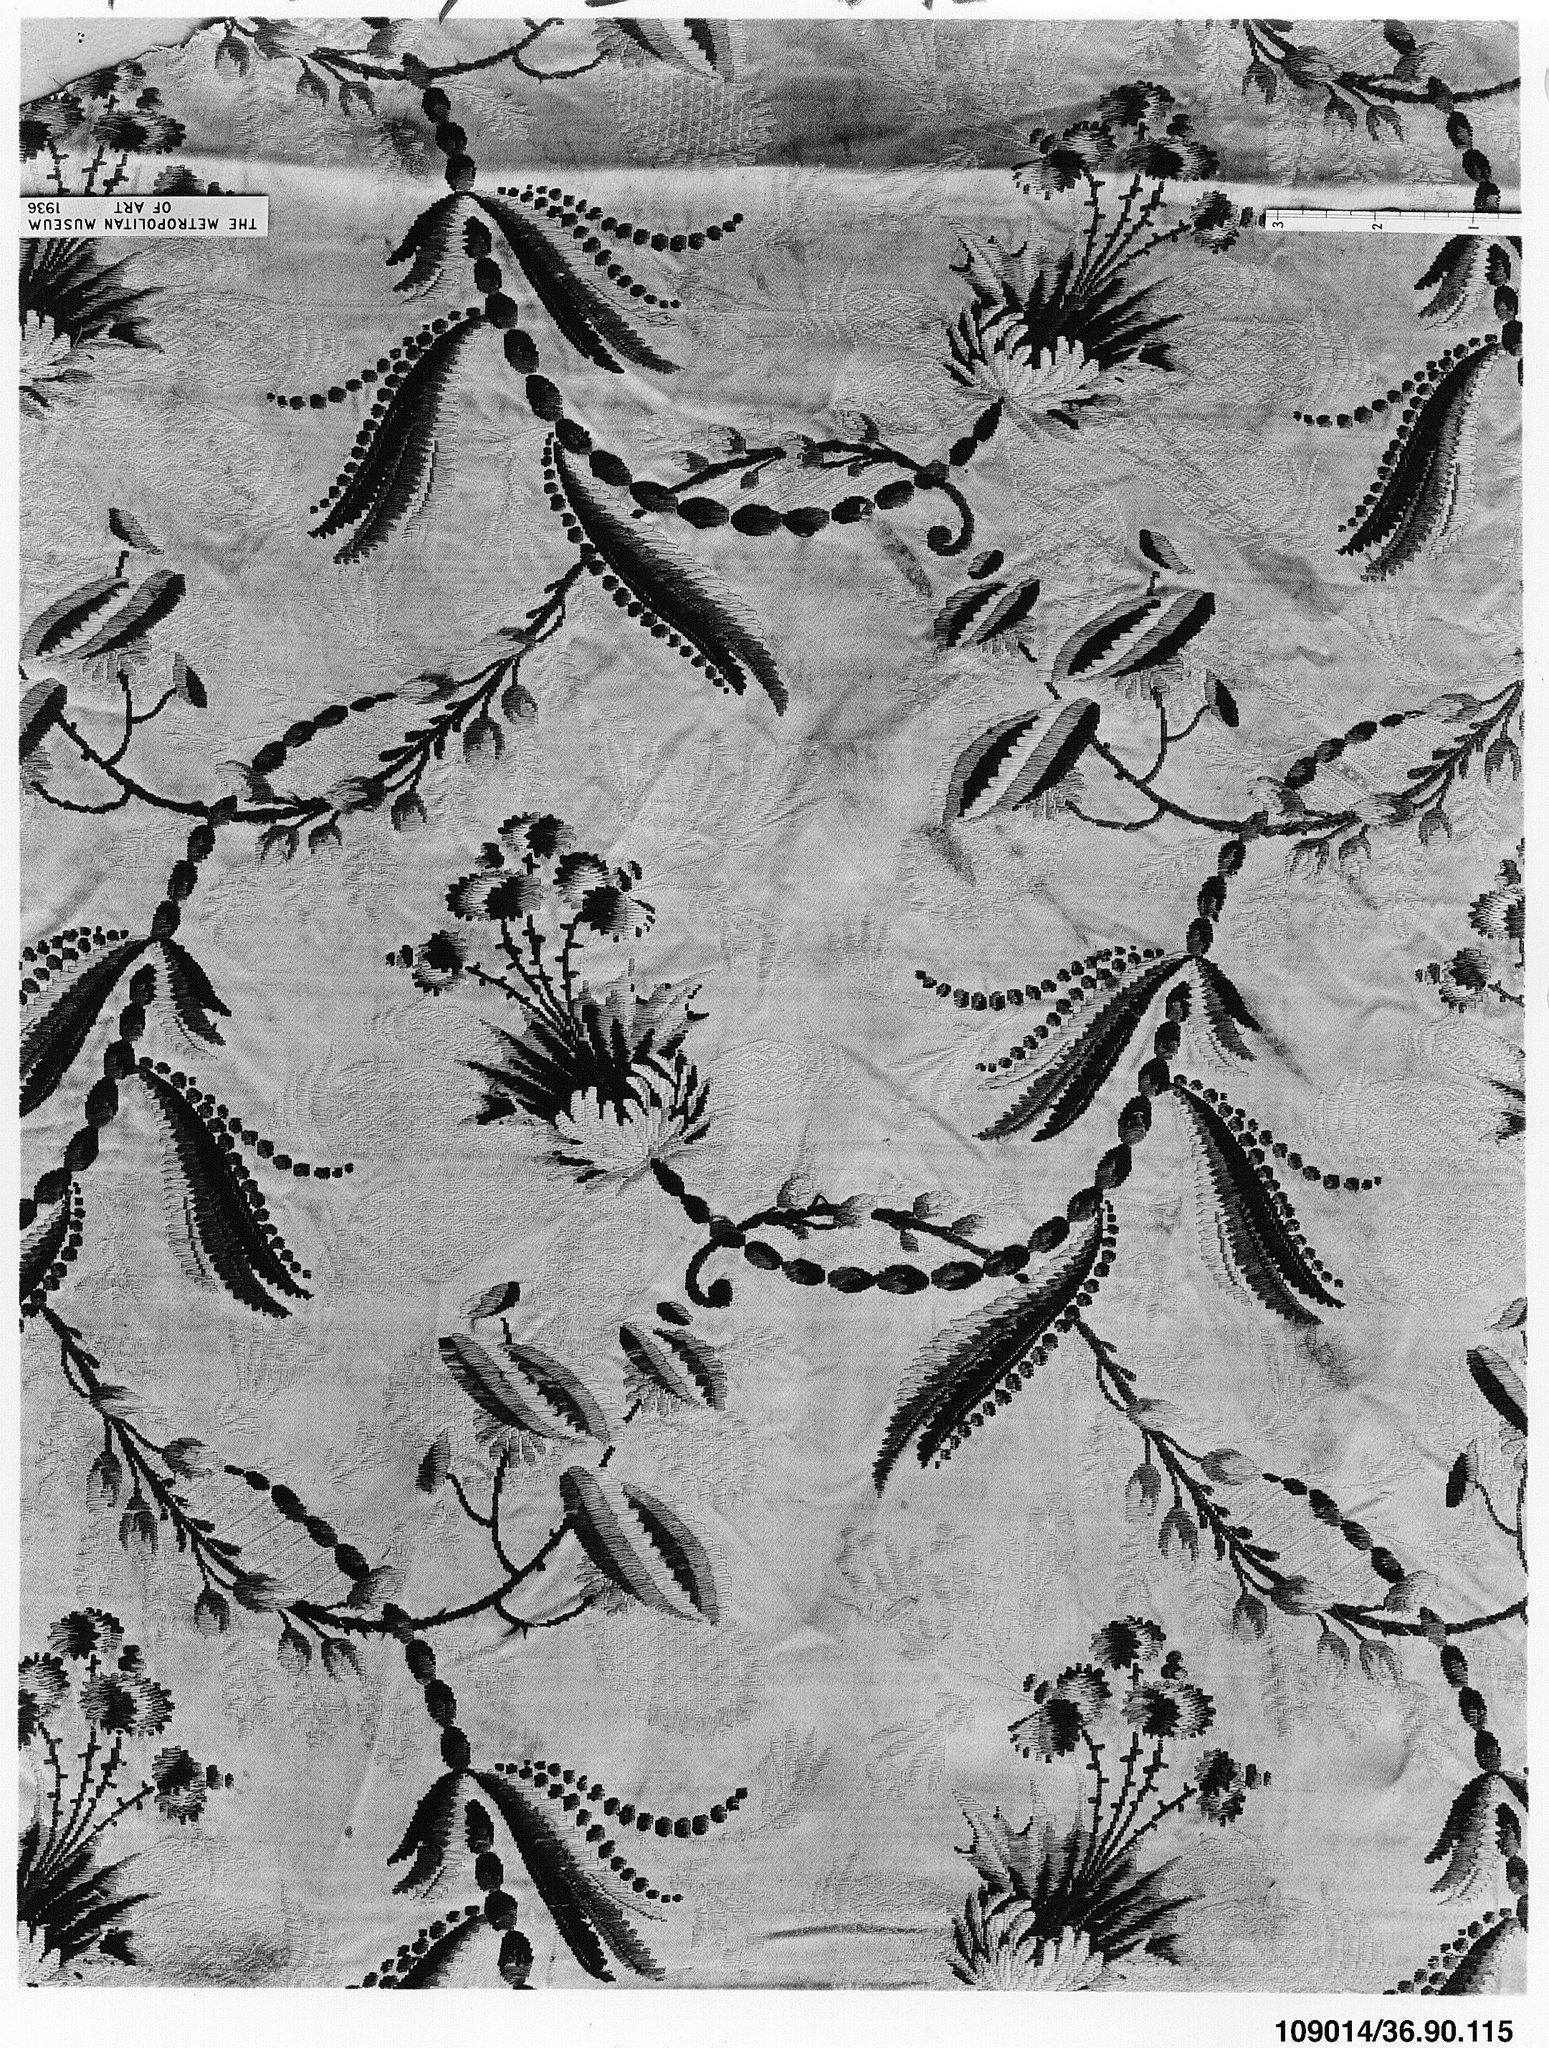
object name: piece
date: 1750-1760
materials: silk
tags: flowers,leaves